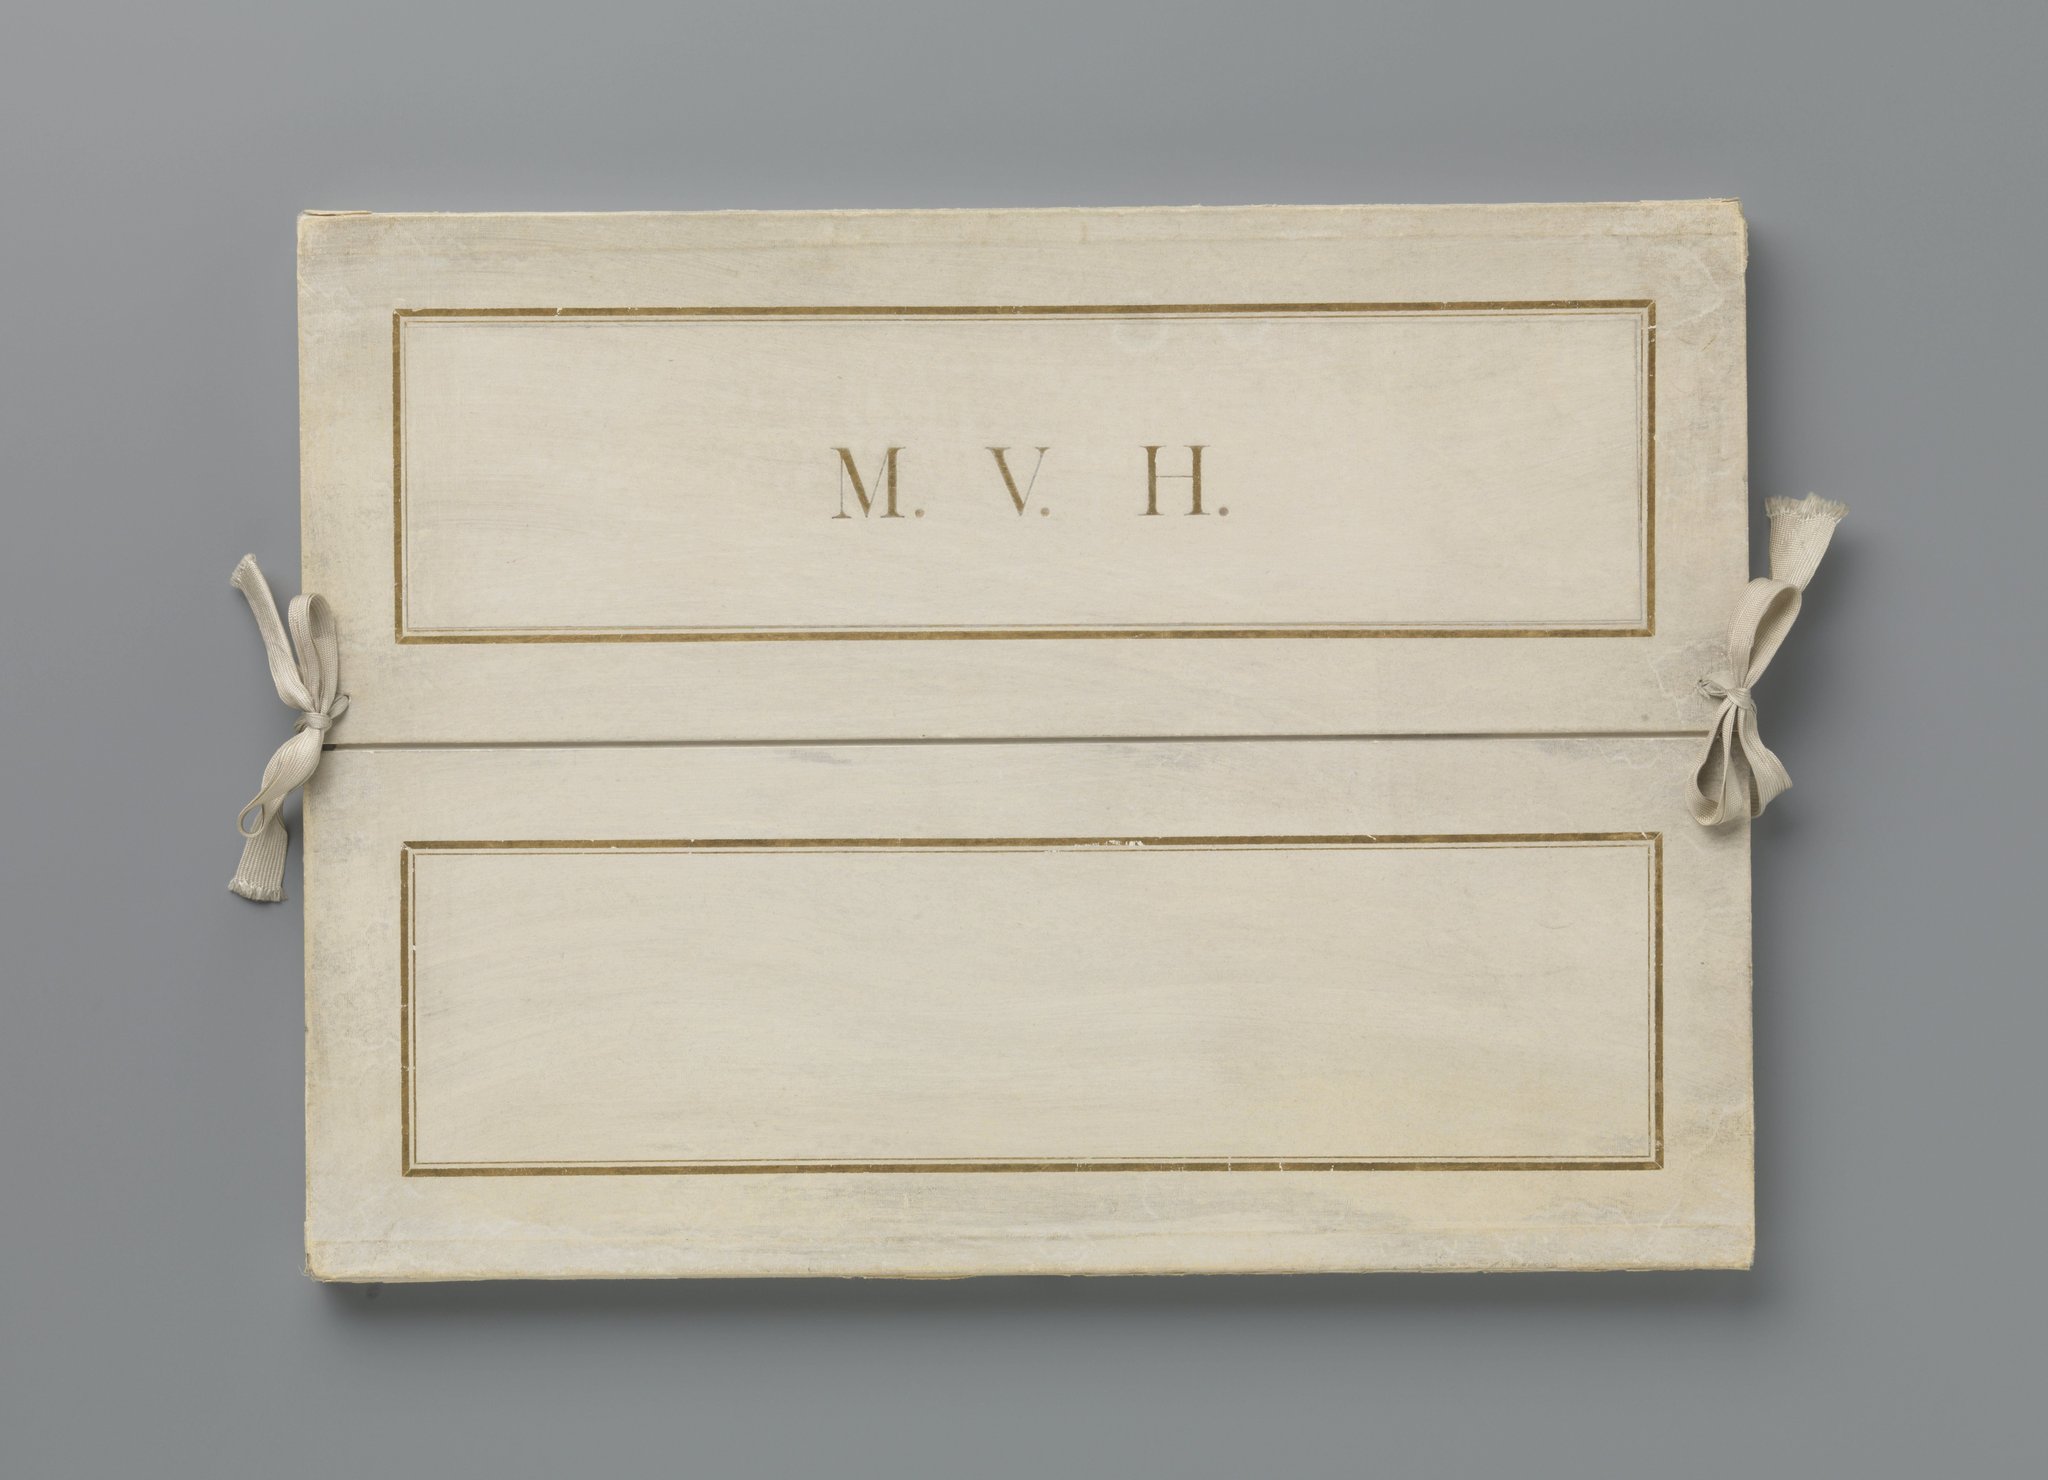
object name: box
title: Doos met het opschrift M.V.H. behorend bij twee japonstroken van kloskant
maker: house of worth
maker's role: modehuis, modewarenhuis, modewinkel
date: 1875-1899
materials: cardboard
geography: paris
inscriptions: : ‘WORTH’, : ‘M.V.H.’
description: Lichtgrijze platte, kartonnen doos met goud opgedrukte omlijning en de letters M.V.H.. Links en rechts grijze, zijden linten om de bovenzijde, die kan worden open geklapt, te sluiten. De binnenzijde is met lichtblauw papier bekleed en heeft op de bovenste dekselhelft in goud het opschrift WORTH. Op de bodem van de doos zijn links en rechts twee lange lichtblauwe linten gestrikt om een karton, die iets donkerder blauw is dan de binnenkant van de doos. De linten waren oorspronkelijk gestrikt over de twee kantstroken heen, die in de doos horen. De initialen M.V.H. staan voor Mary (Ethel) Vernon Harcourt, Viscountess Harcourt (voor haar trouwen met Lewis Vernon Harcourt, 1st Viscount Harcourt heette ze Haynes Burns).